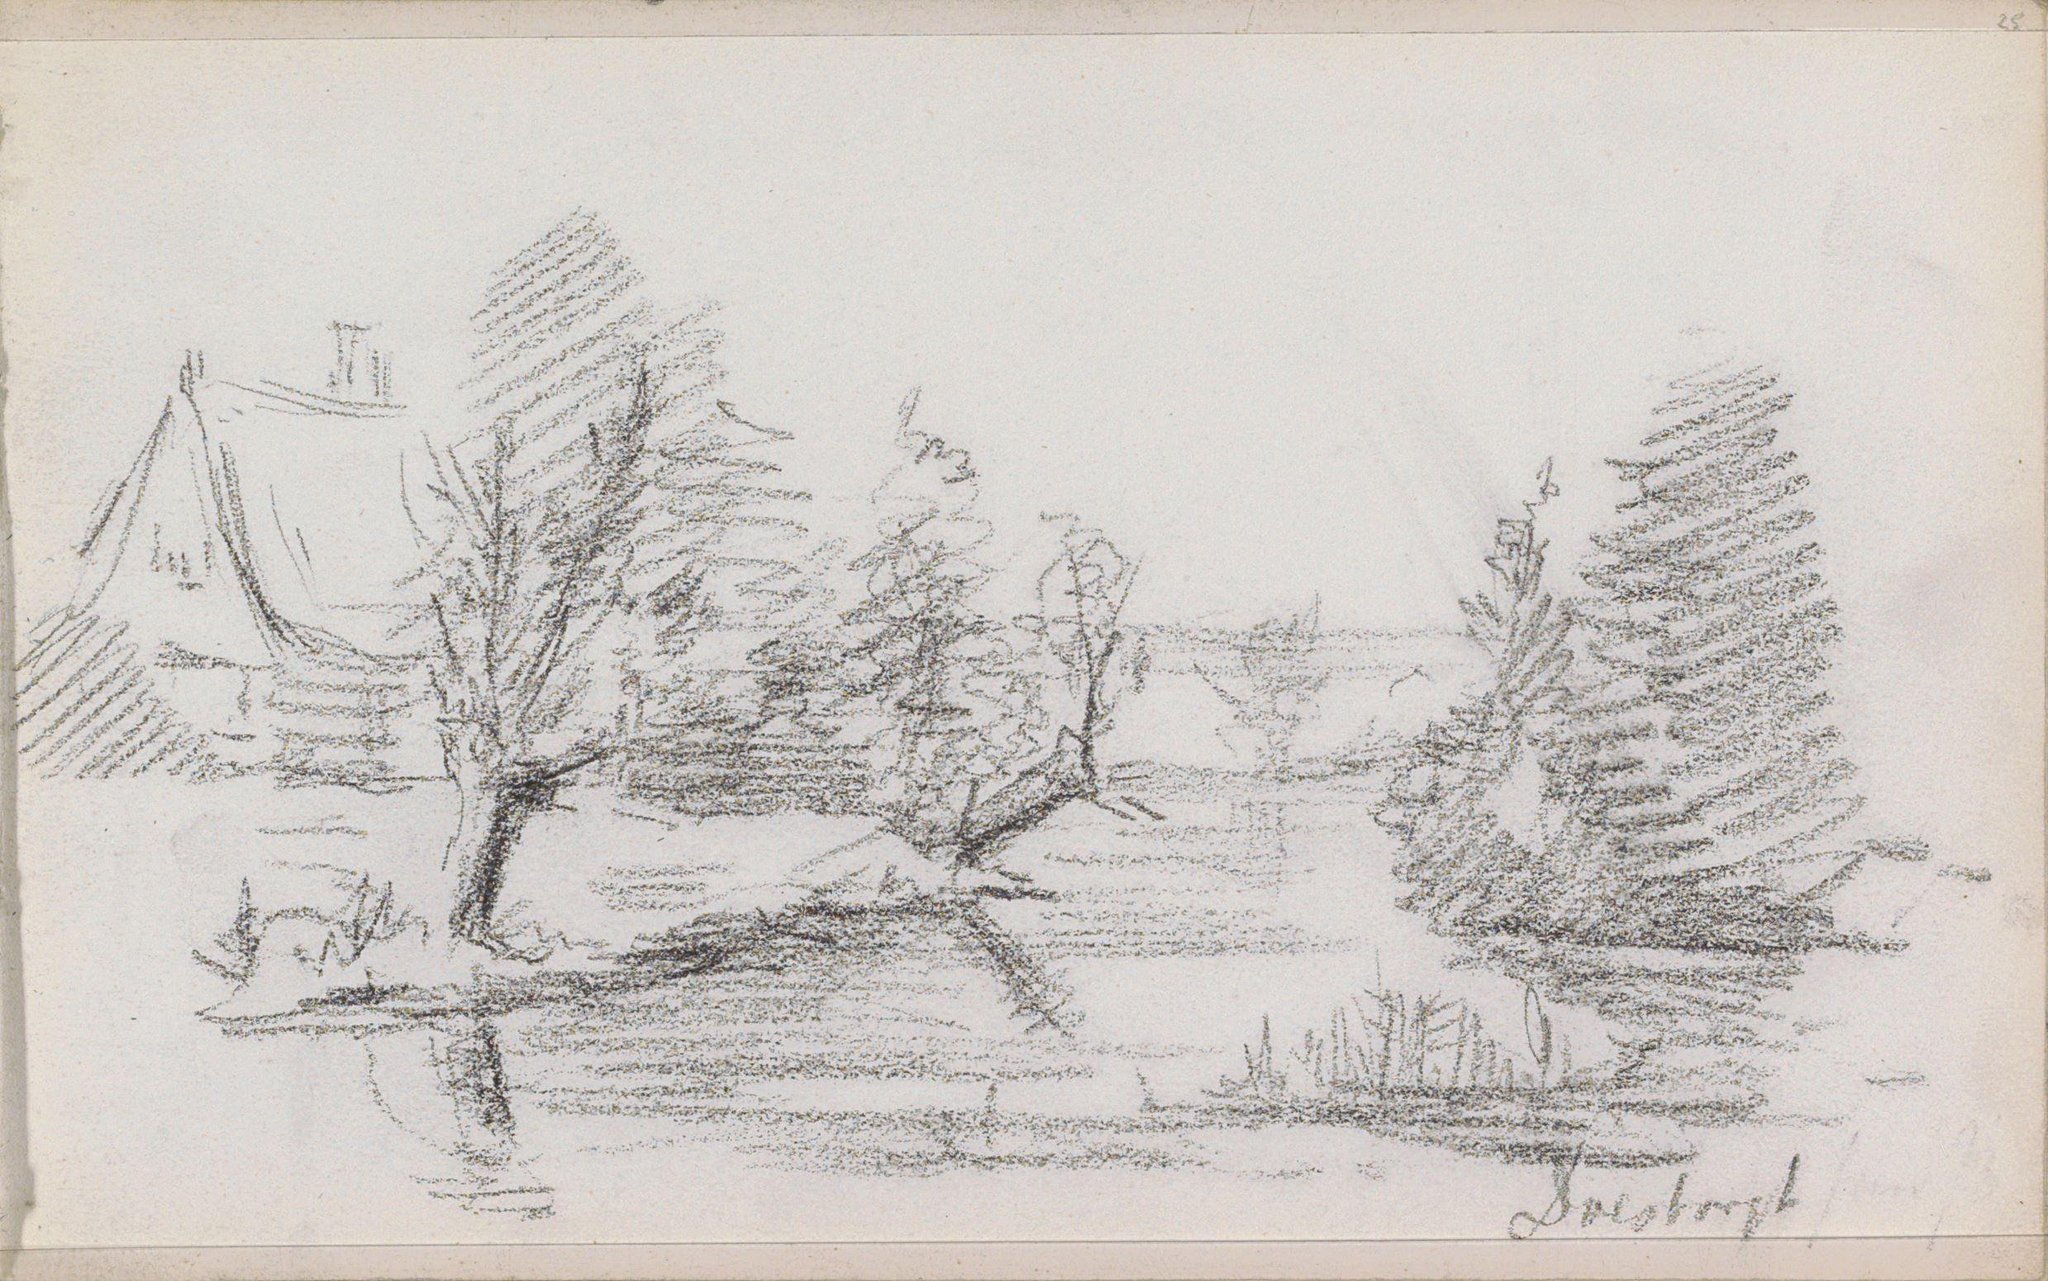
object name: sketchbook leaf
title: Huis aan het water in Doesburg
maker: willem witsen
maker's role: draughtsman, painter, print maker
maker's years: 1860-1923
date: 1806-1878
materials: chalk, paper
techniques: stumping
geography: doesburg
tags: water course, civic architecture; edifices; dwellings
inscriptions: date: ‘Juni 78.’, annotation: ‘Doesborgh’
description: Pagina 25 uit een schetsboek met 23 bladen.